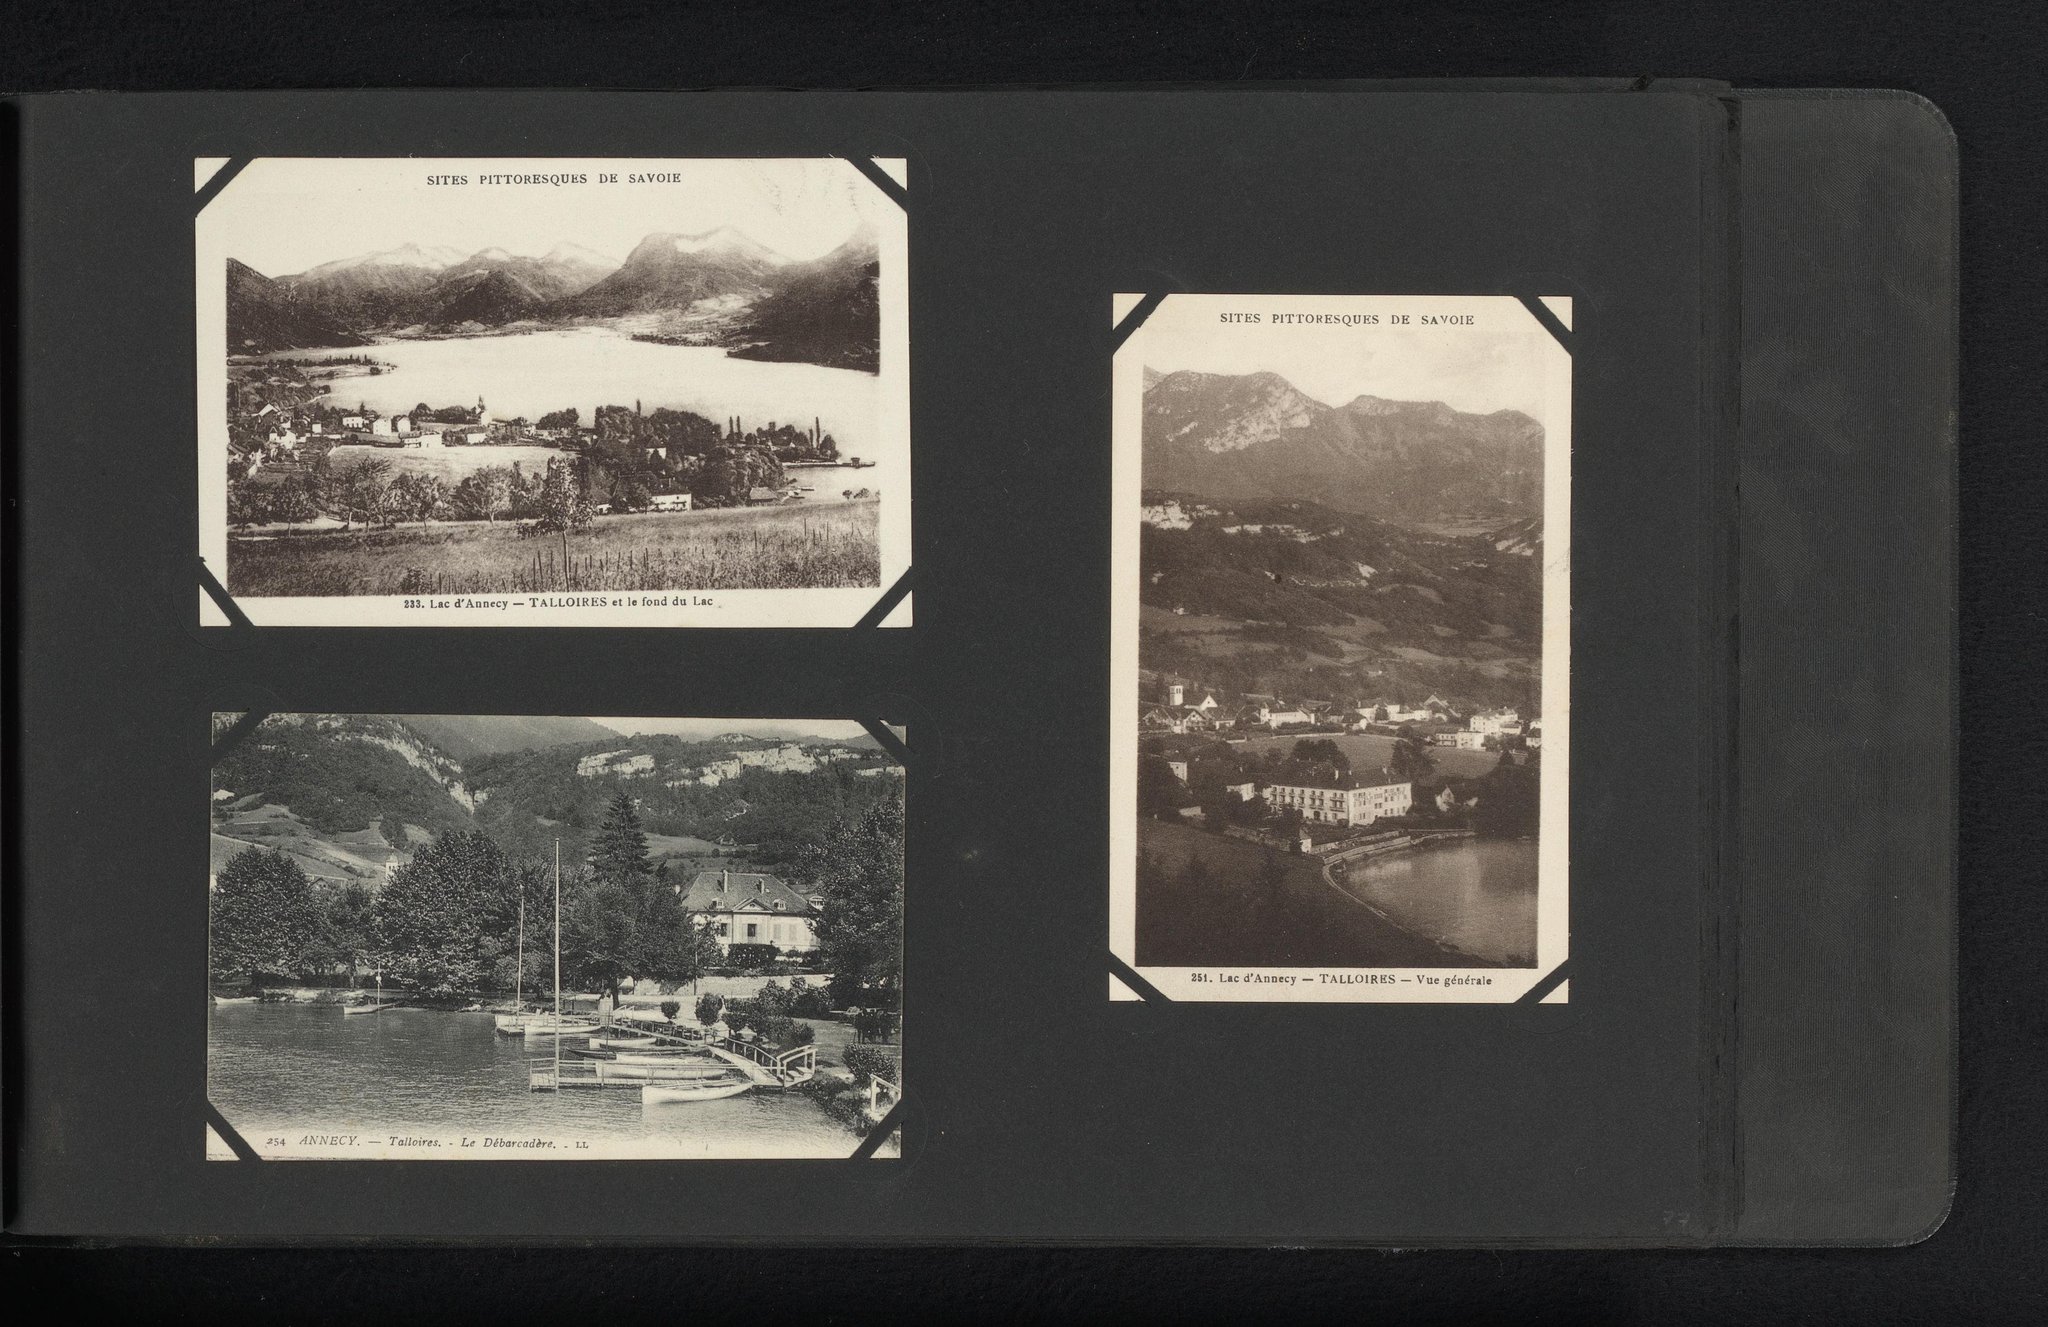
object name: album leaf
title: Drie fotomechanische prentbriefkaarten van Annecy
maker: Anonymous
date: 1908-1929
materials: cardboard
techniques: photograph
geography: paris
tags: lake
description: Deze prenten maken deel uit van een album.